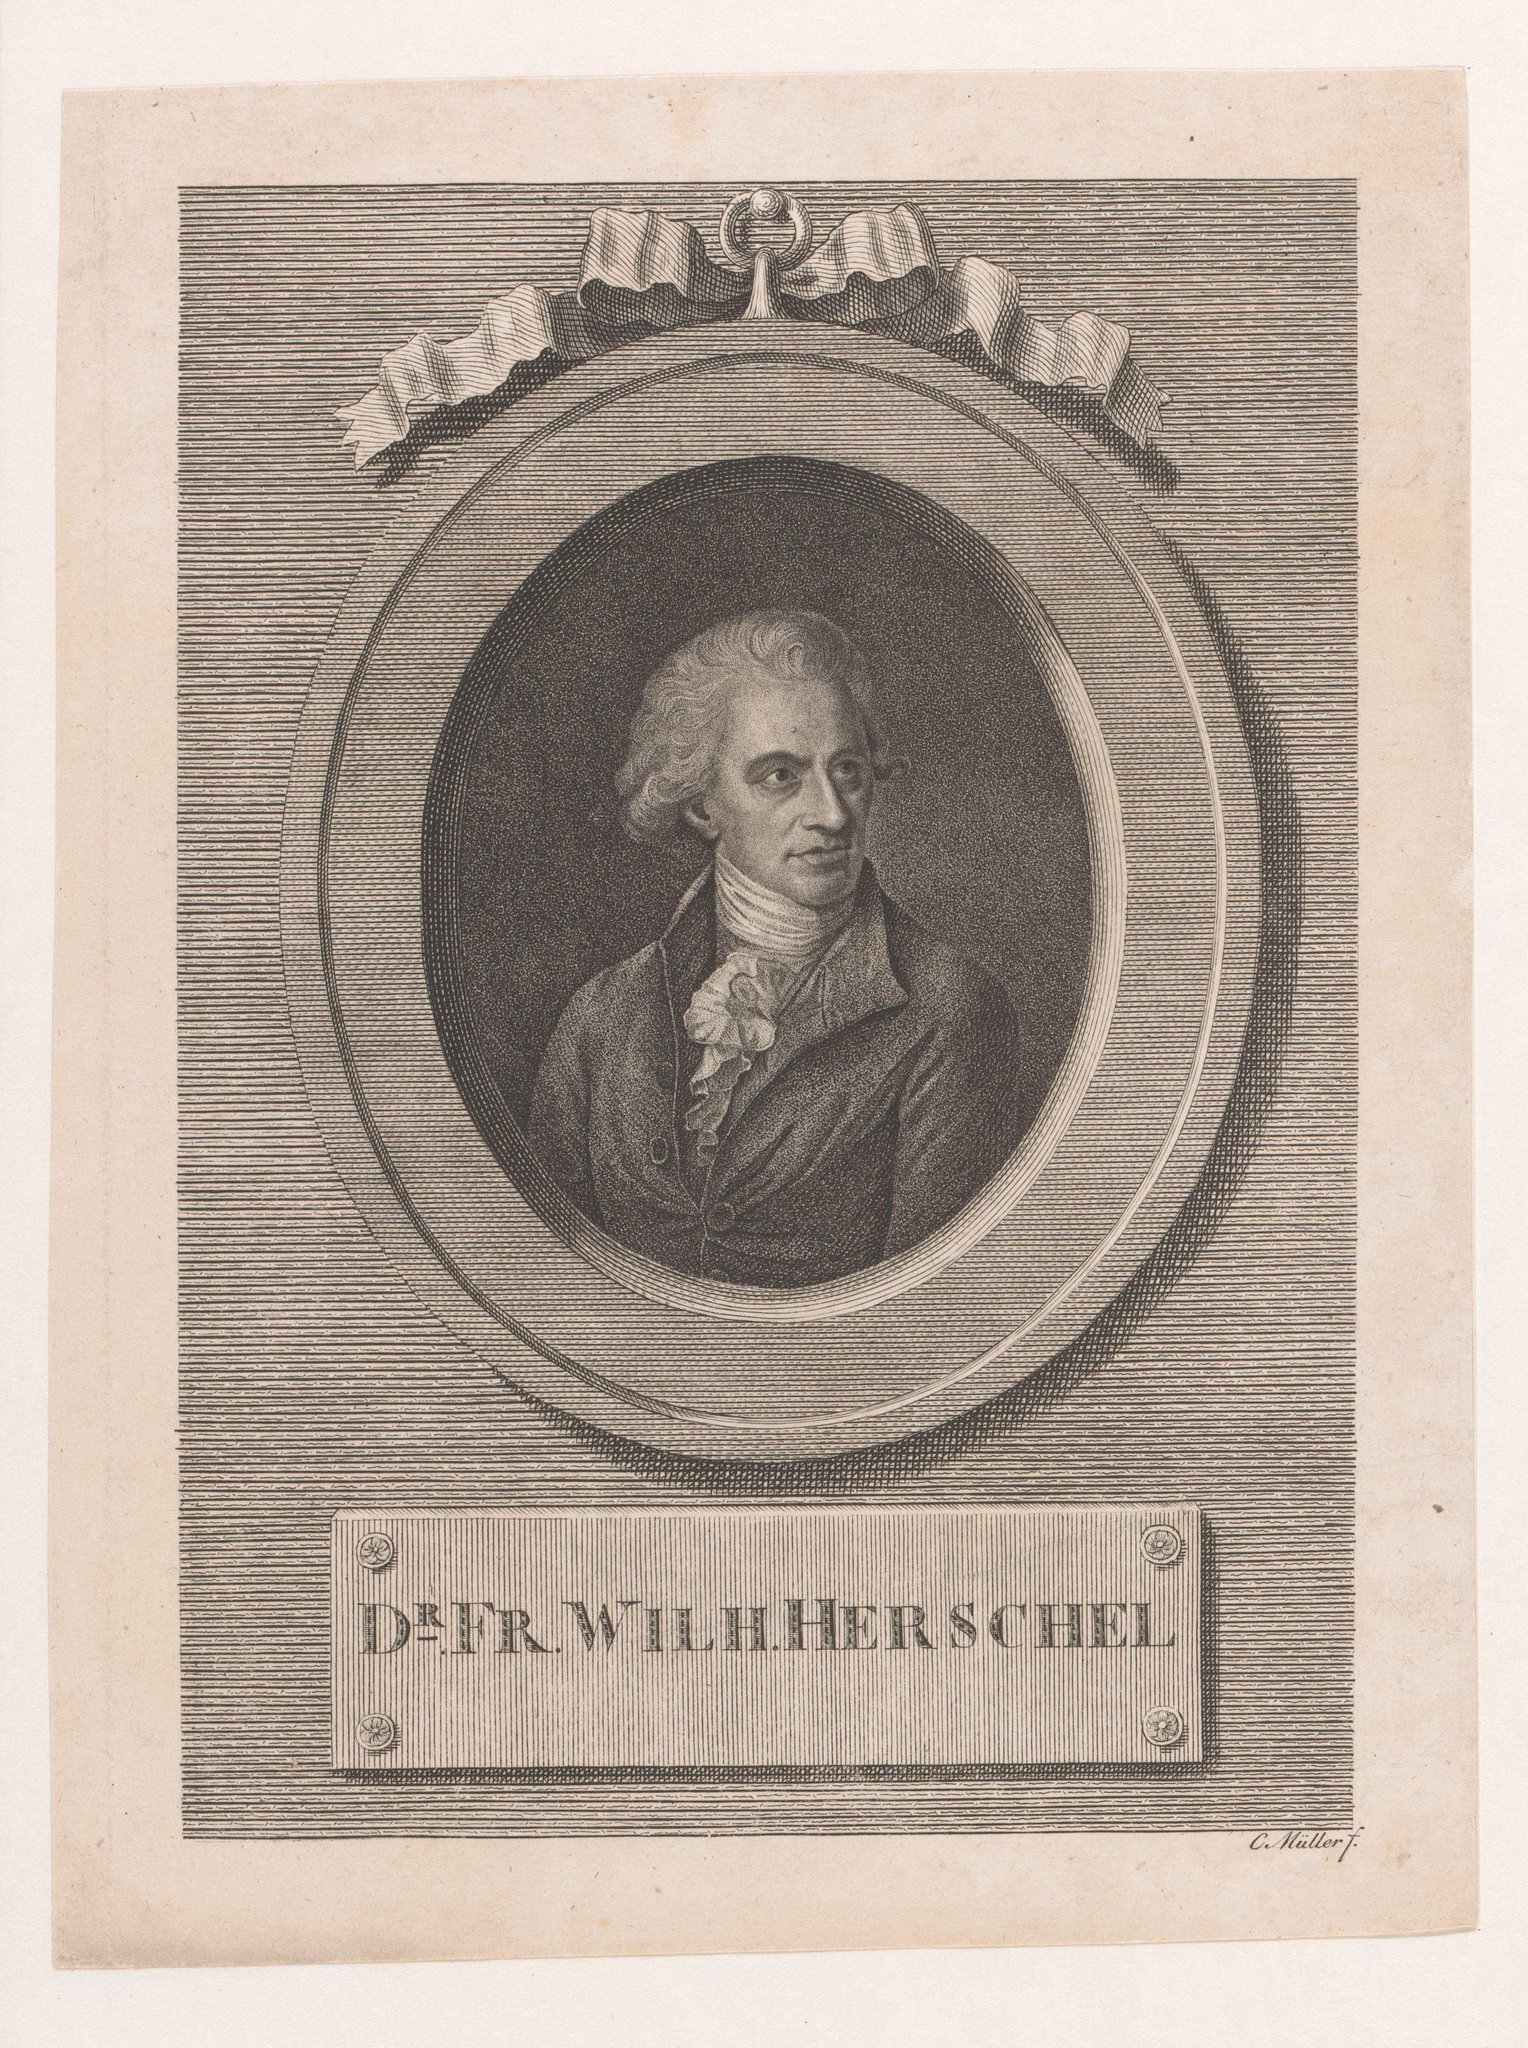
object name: print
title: Portret van Frederick William Herschel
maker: johann christian ernst müller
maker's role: draughtsman, print maker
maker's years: 1766-1824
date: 1776-1824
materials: paper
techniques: engraving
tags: england, historical persons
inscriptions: collector's mark: Lugt 2228